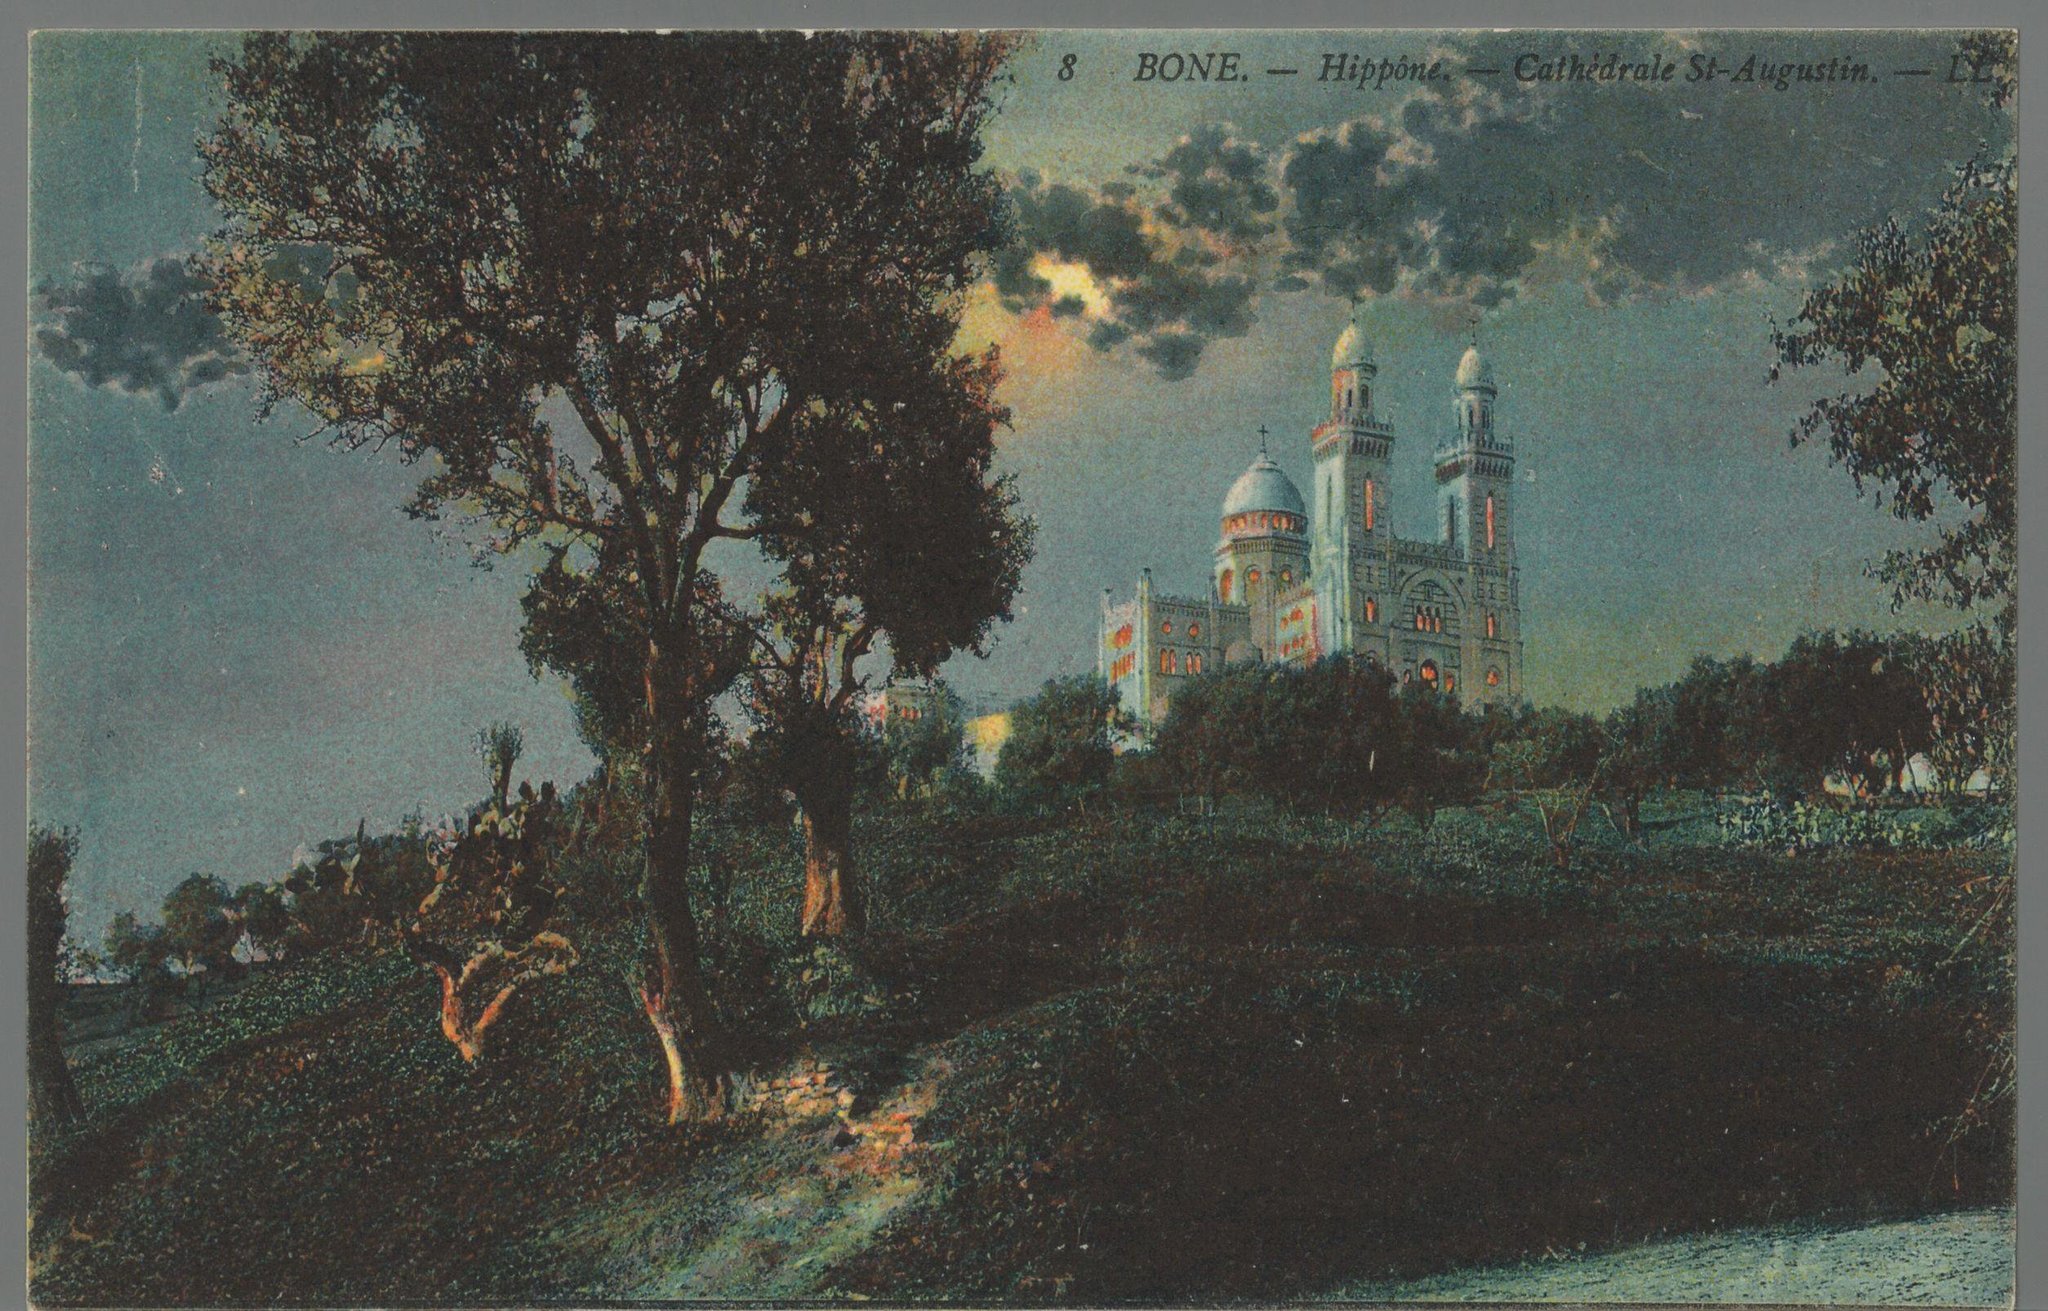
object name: photomechanical print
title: Bone. Hippône. Cathédrale St. Augustin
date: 1903-1905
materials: cardboard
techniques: photograph, lithograph, writing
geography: paris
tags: church (exterior), night